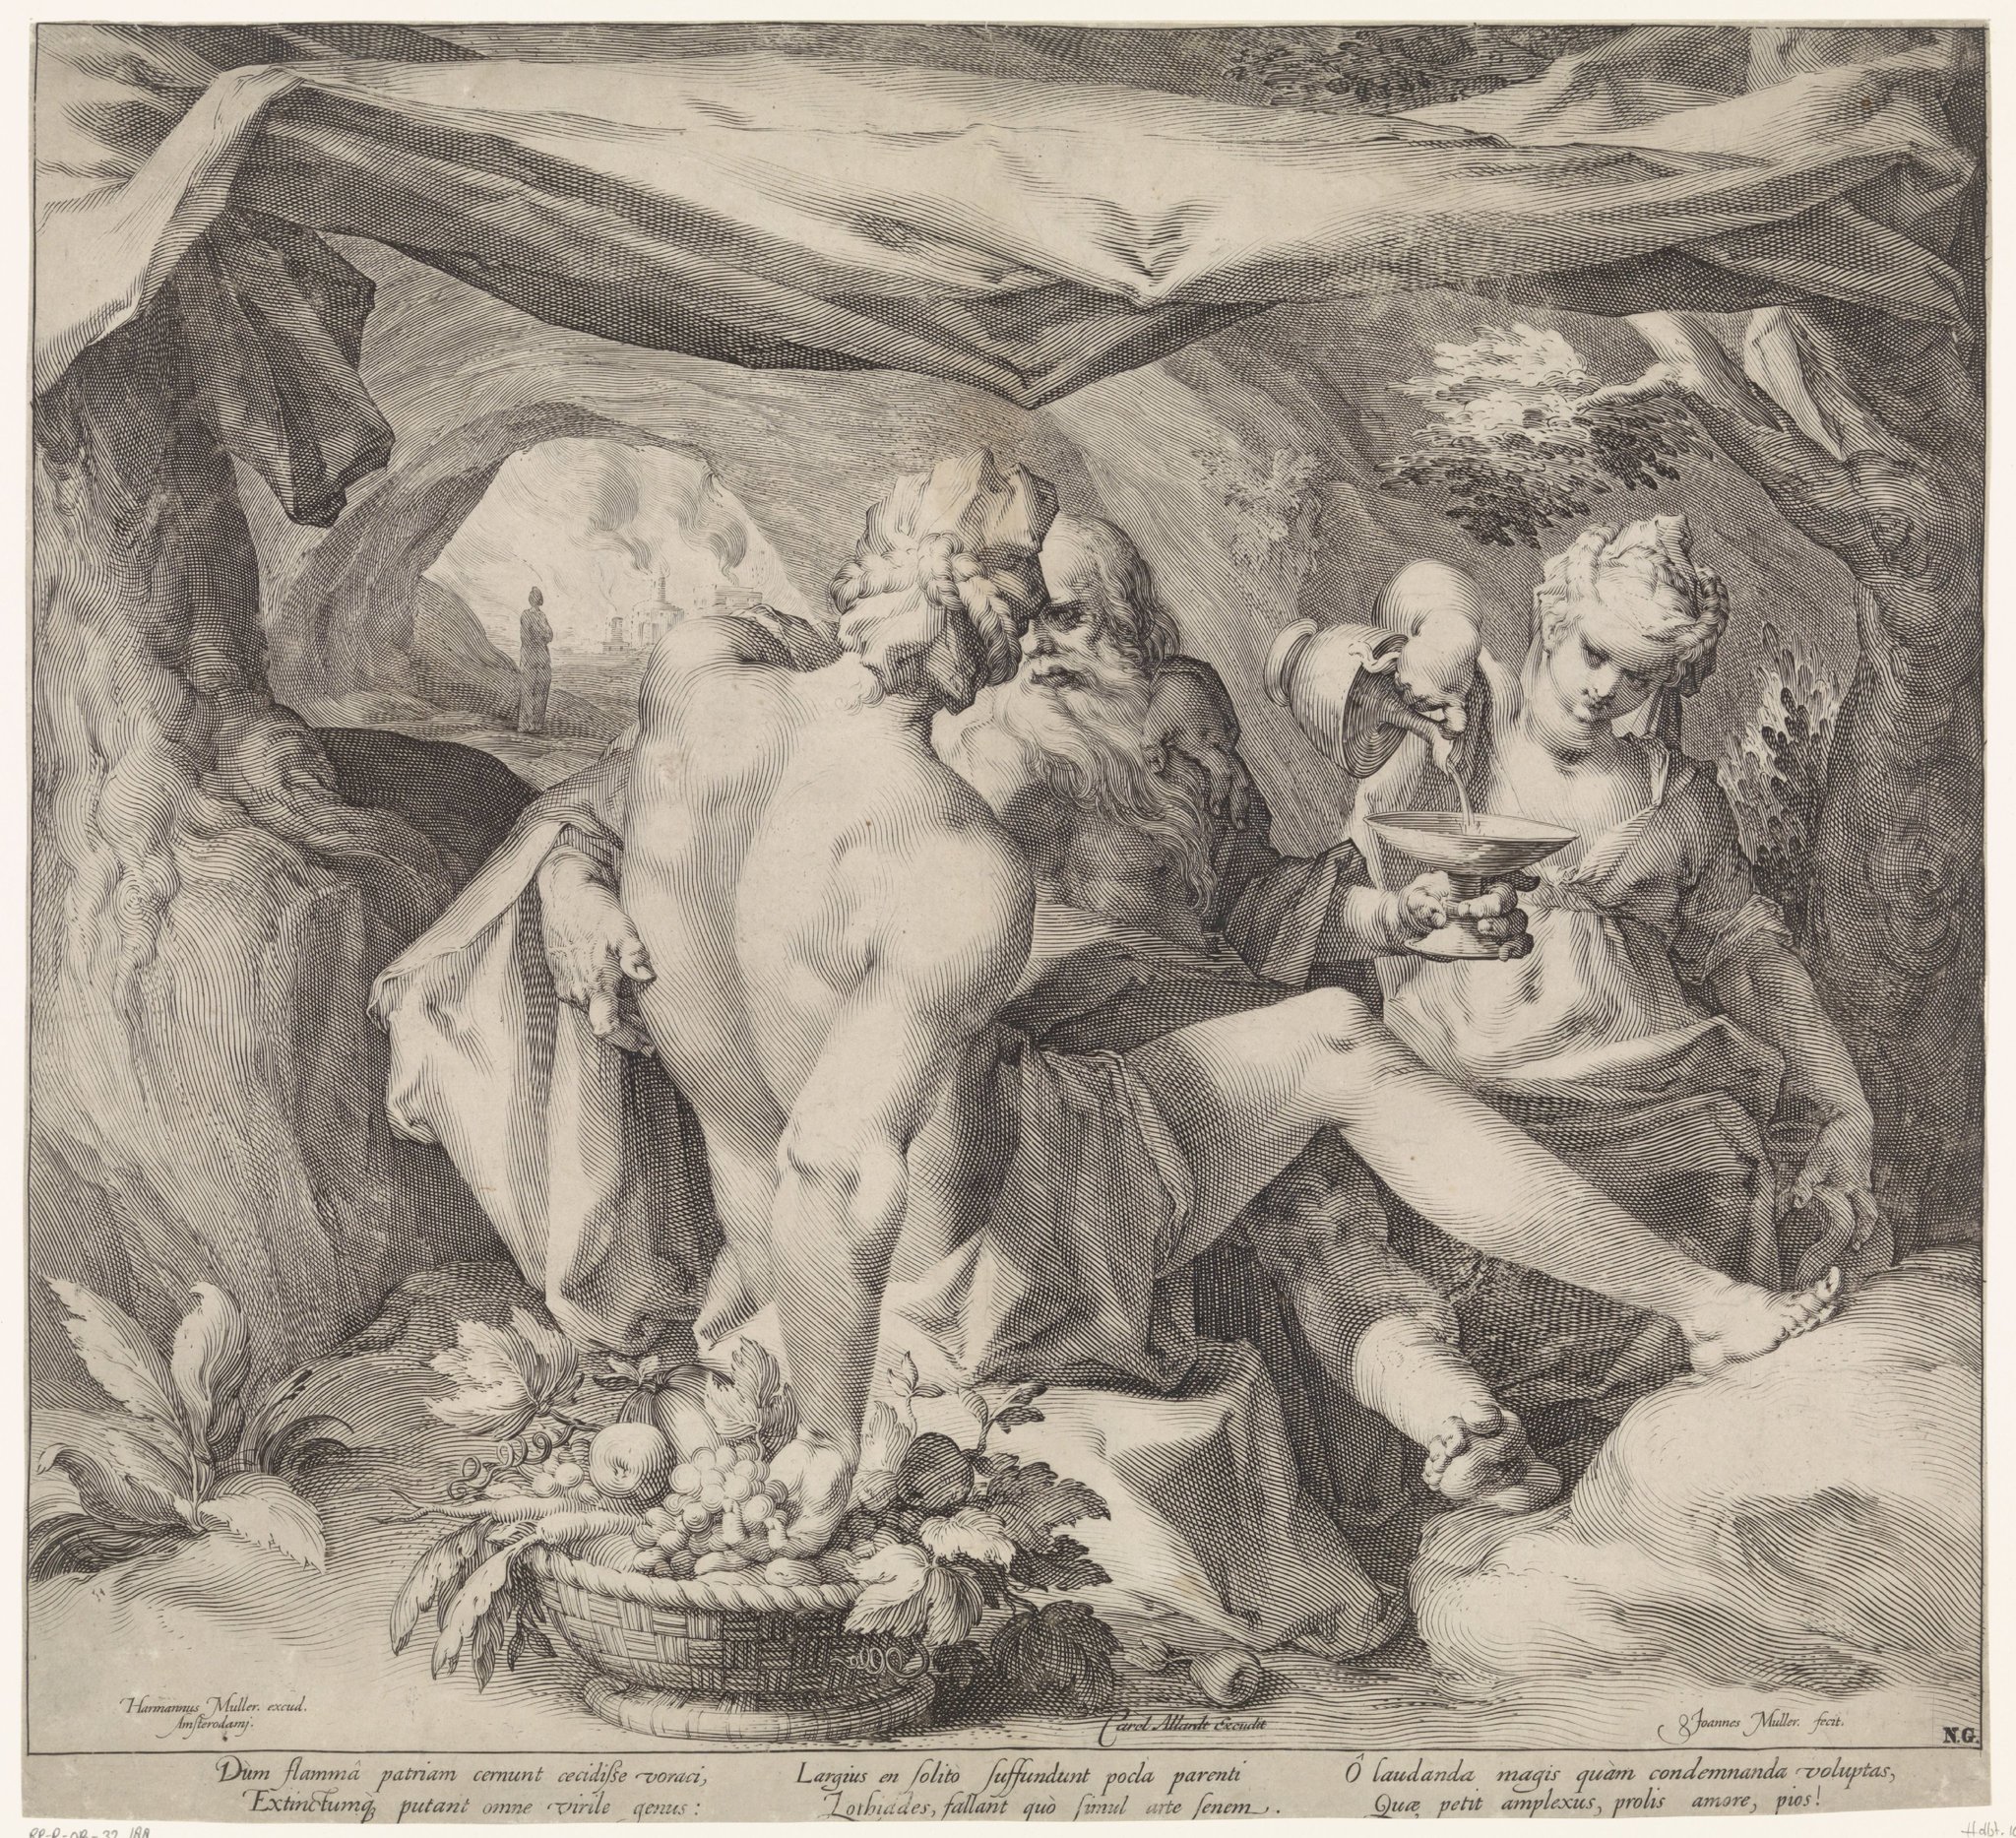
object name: print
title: Lot en zijn dochters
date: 1598-1602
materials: paper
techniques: engraving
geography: amsterdam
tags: lot and his daughters (genesis 19:30-38)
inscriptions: collector's mark: Lugt 1967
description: Lot zit met zijn dochters in een grot en wordt door hen dronken gevoerd. Op de achtergrond de brandende steden Sodom en Gomorra en de vrouw van Lot als zoutpilaar. Onderaan in de marge drie tweeregelige verzen in het Latijn over de voorstelling.